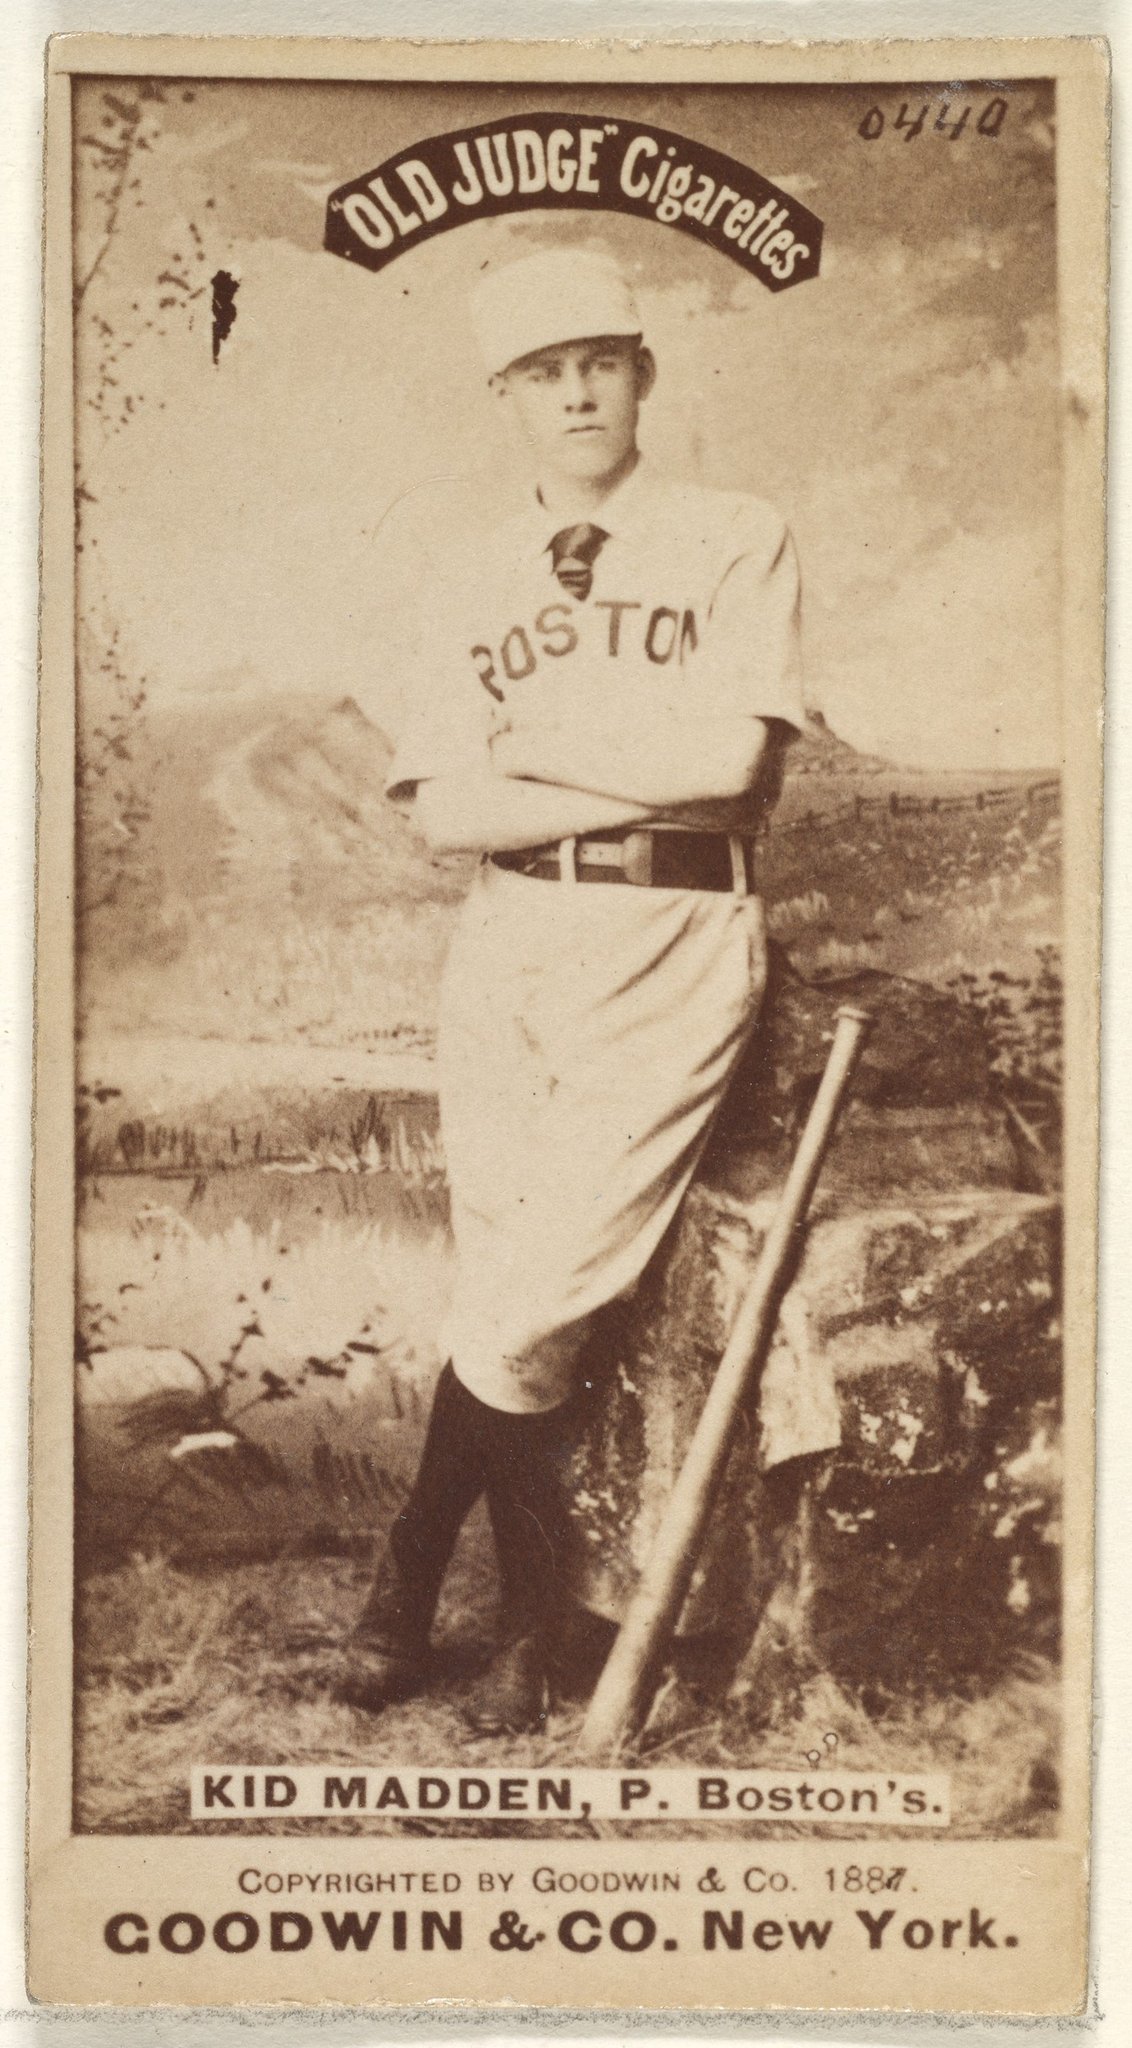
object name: baseball card, photograph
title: Kid Madden, Pitcher, Boston, from the Old Judge series (N172) for Old Judge Cigarettes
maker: goodwin & company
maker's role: publisher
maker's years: 1850-1950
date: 1887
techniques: albumen silver print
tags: men,portraits,baseball,athletes